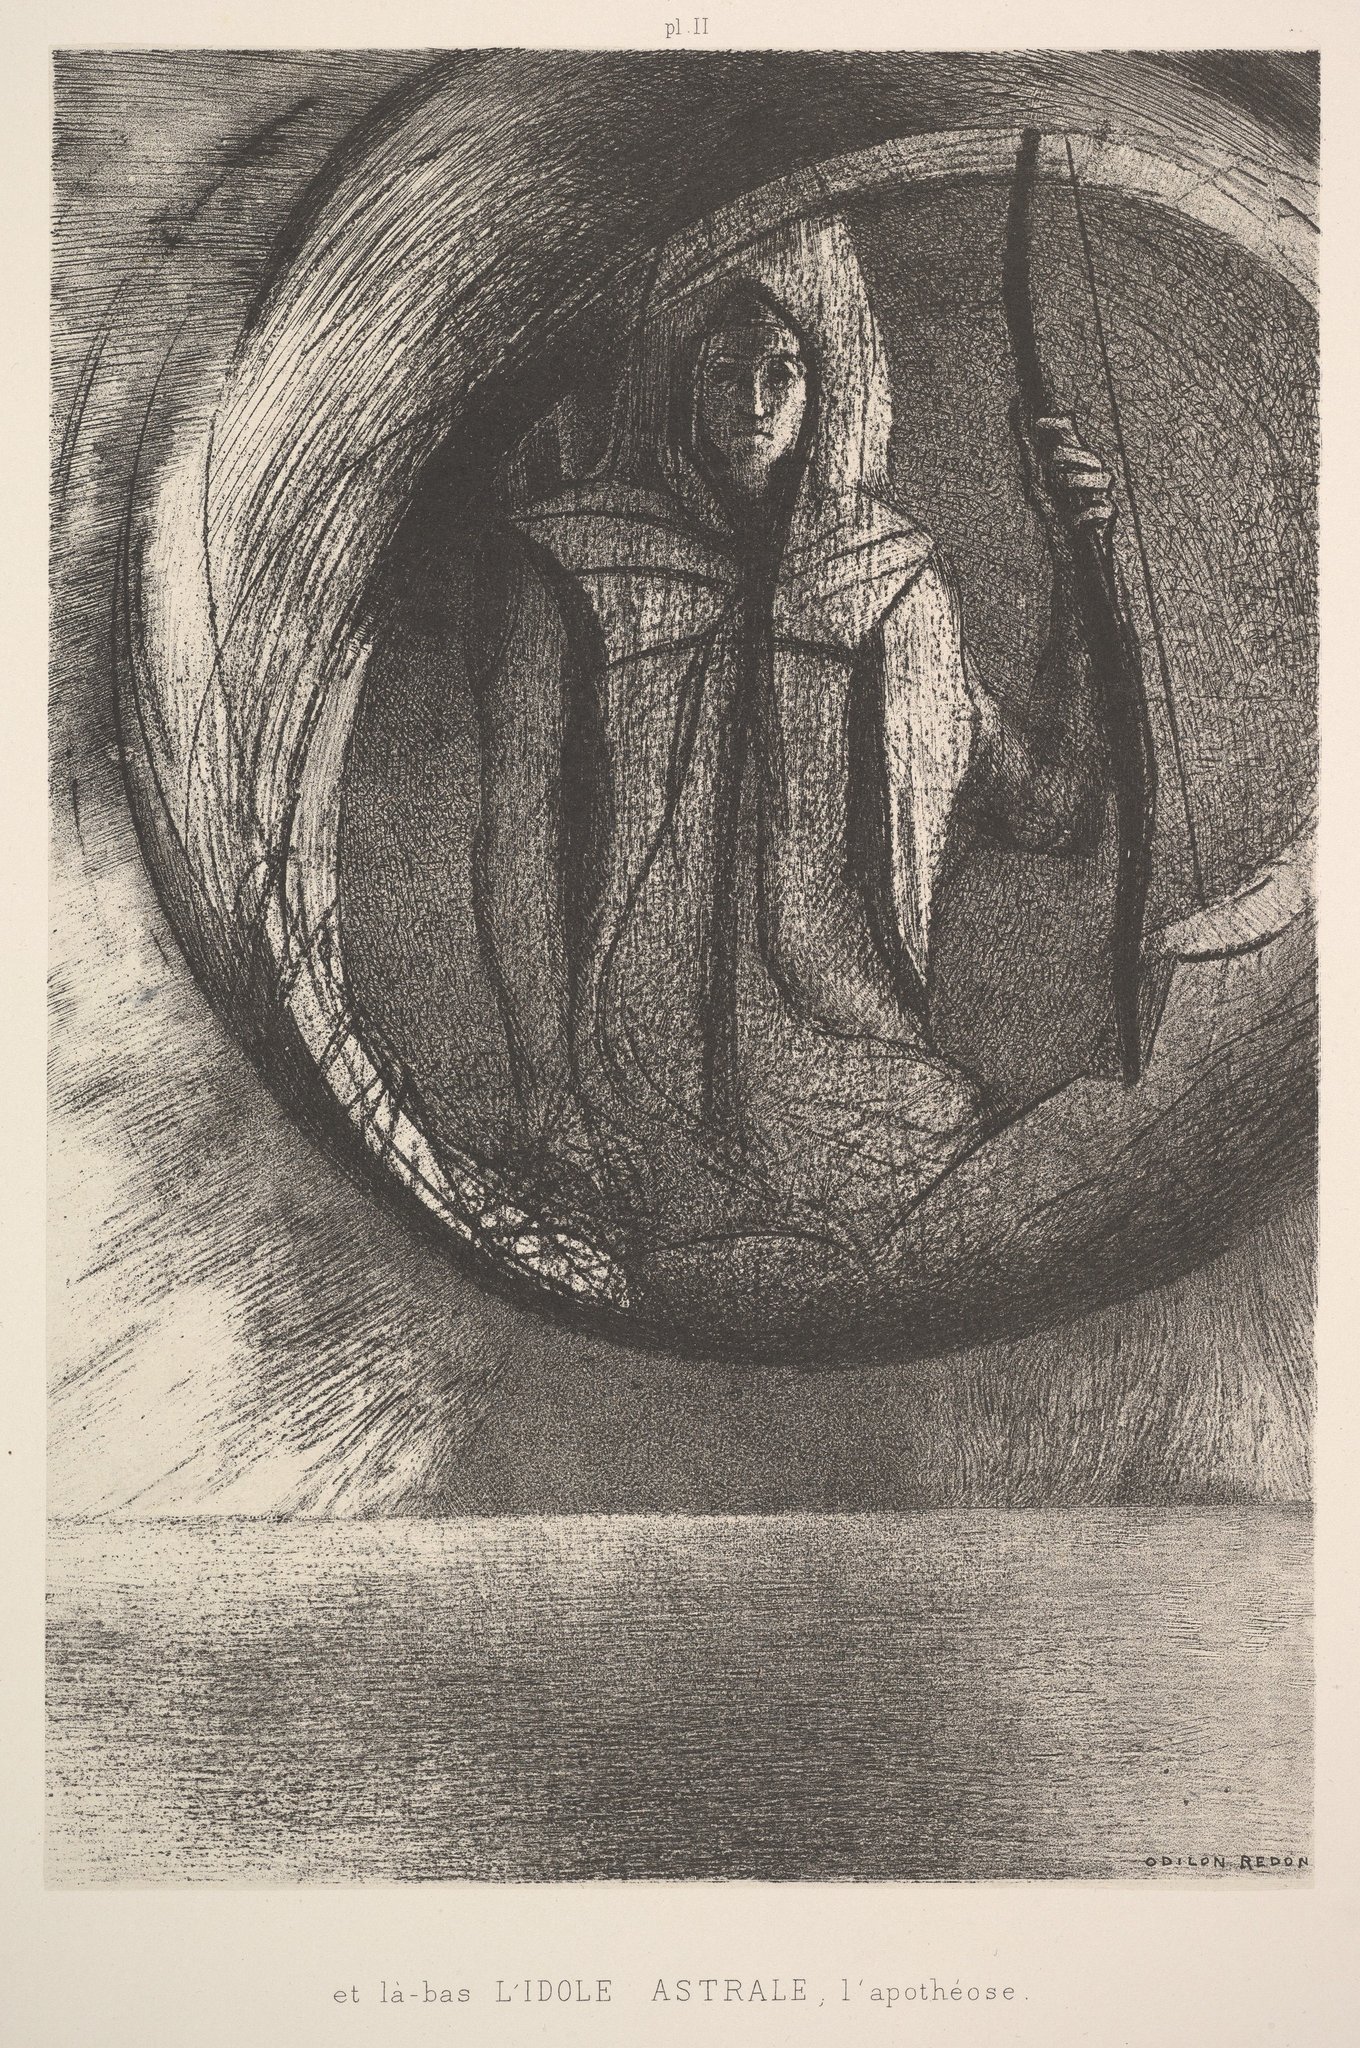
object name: print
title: And over there, the Astral Idol, the Apotheosis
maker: odilon redon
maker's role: artist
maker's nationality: french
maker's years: 1840-1916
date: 1891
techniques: lithograph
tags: bow and arrow,men